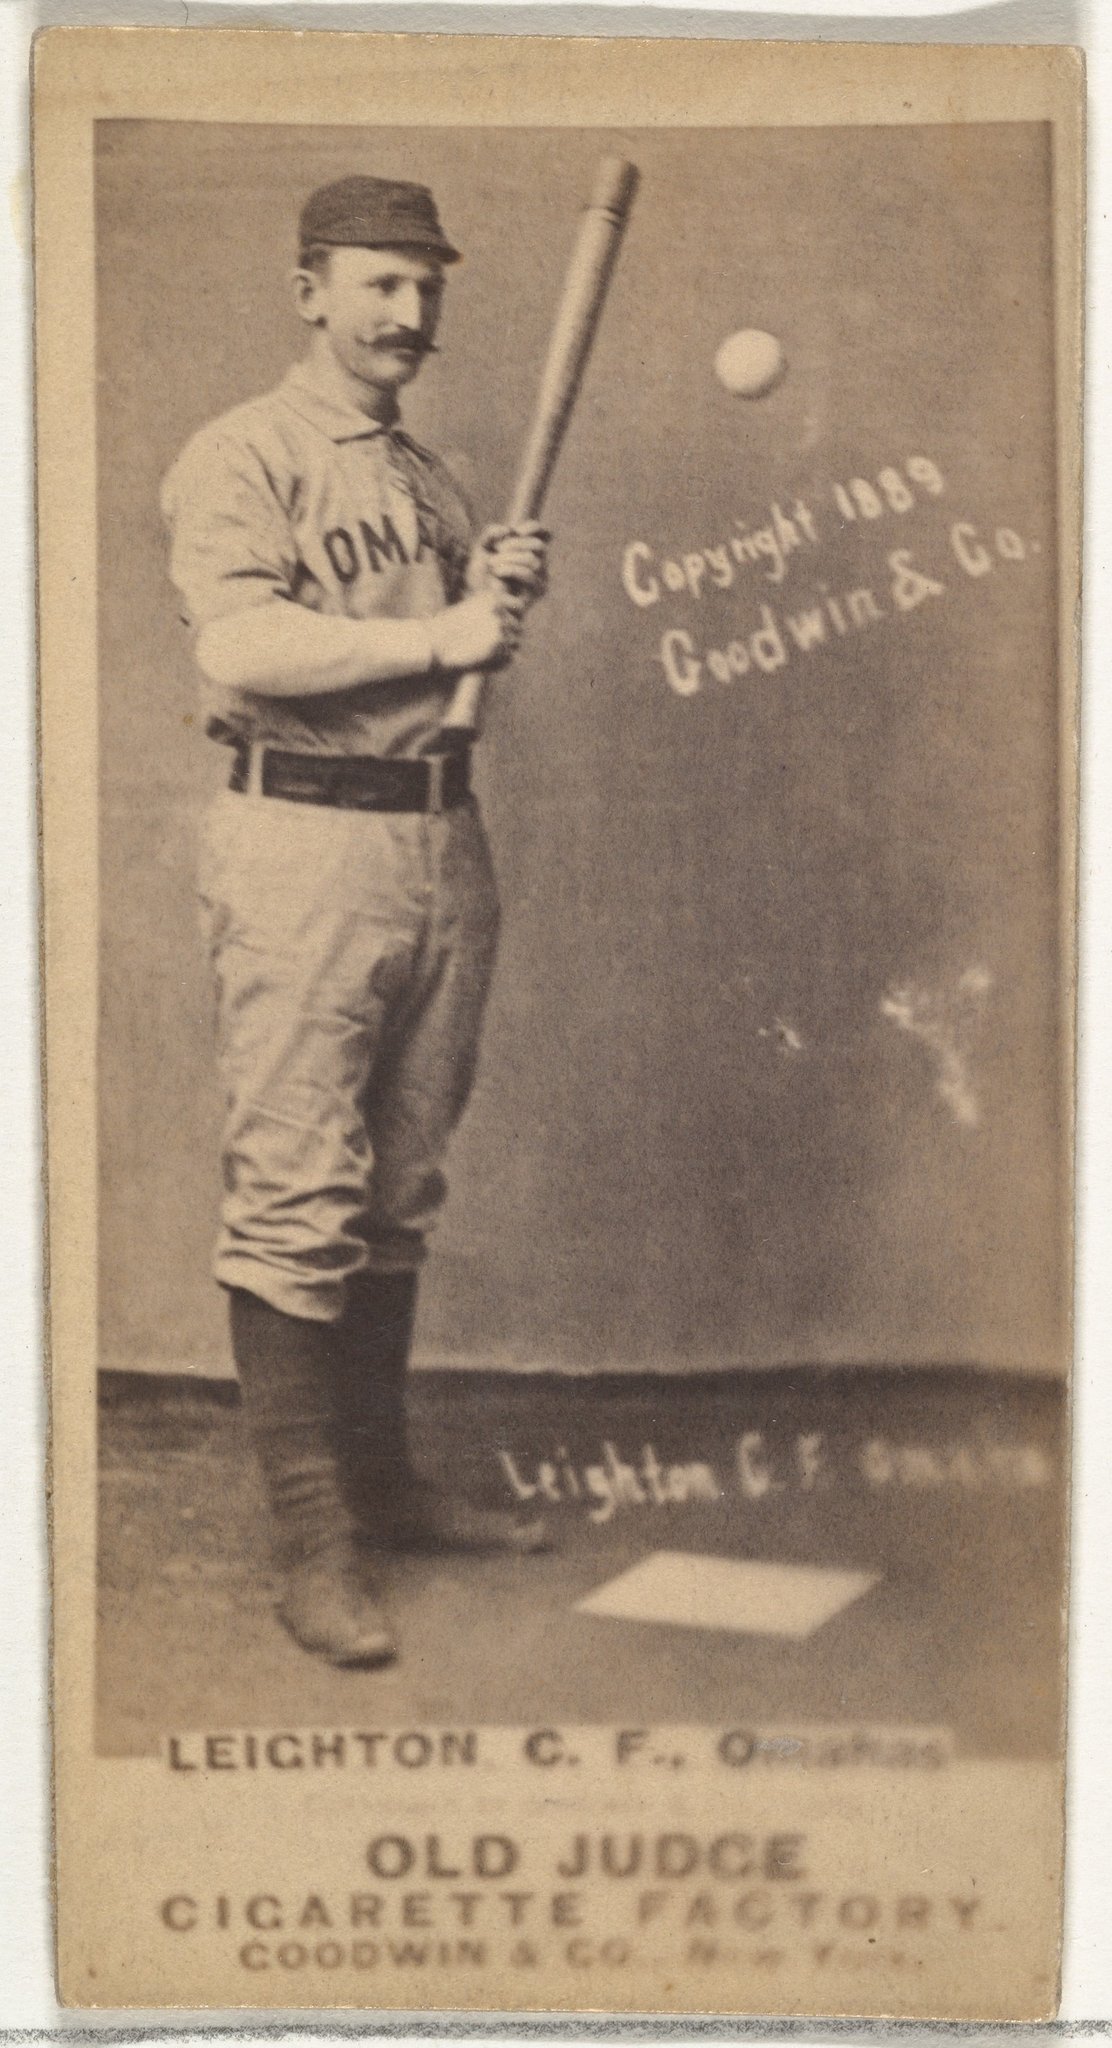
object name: baseball card, photograph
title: Leighton, Center Field, Omaha Omahogs/ Lambs, from the Old Judge series (N172) for Old Judge Cigarettes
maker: goodwin & company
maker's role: publisher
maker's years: 1850-1950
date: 1889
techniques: albumen silver print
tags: men,portraits,baseball,athletes